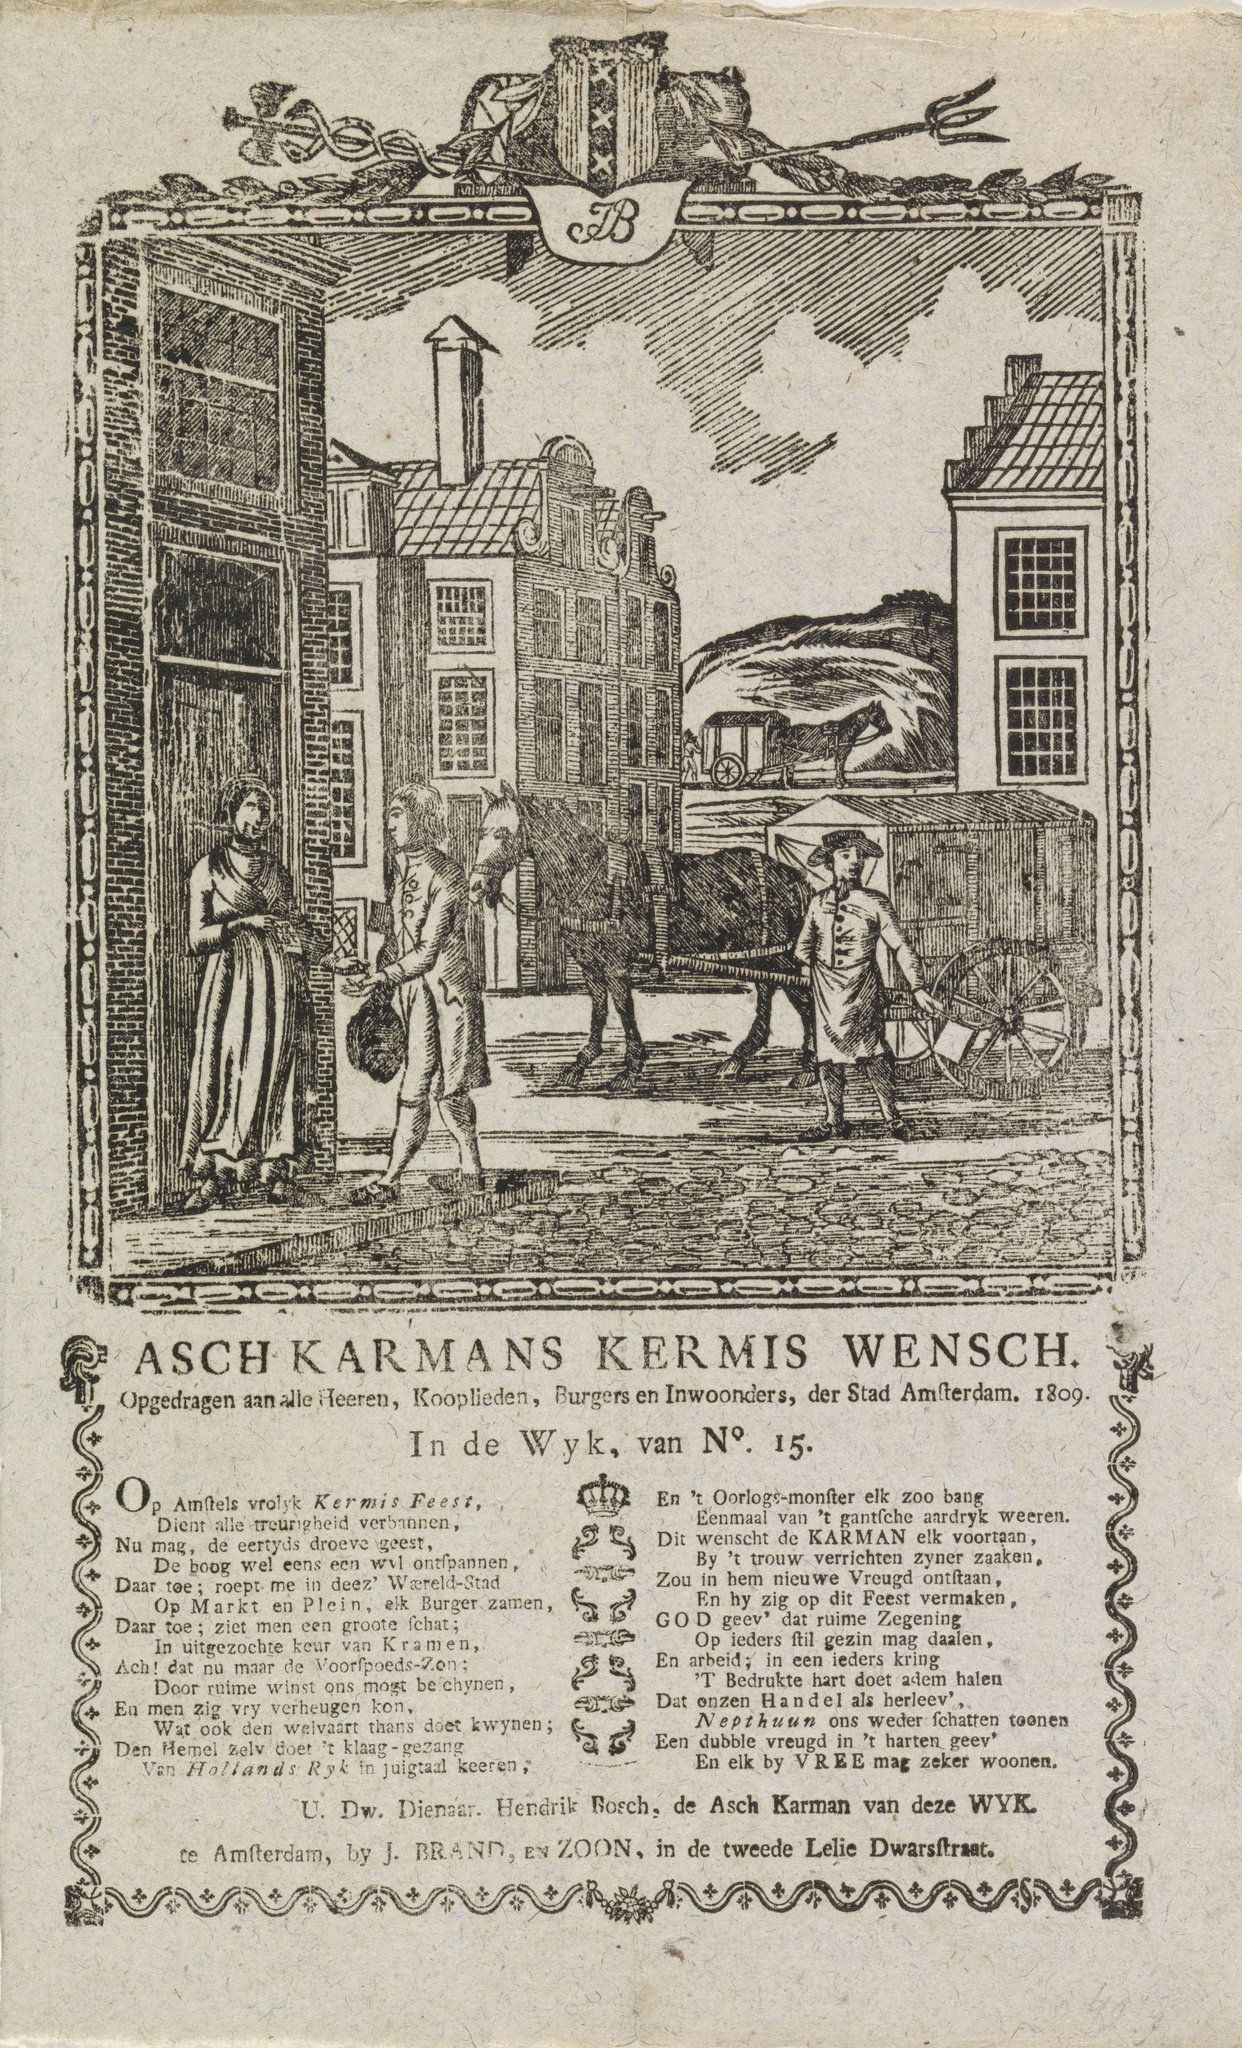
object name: fair print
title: Kermisprent van de Amsterdamse karrenman voor het jaar 1809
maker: j. brand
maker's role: print maker, printer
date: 1809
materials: paper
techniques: letterpress printing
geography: amsterdam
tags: garbage collecting lorry, garbage truck, amsterdam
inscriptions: collector's mark: Lugt 2228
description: Kermisprent voor het jaar 1809 van Hendrik Bosch, de karrenman (askarrenman of vuilnisman) in de wijk 15, opgedragen aan de burgers van Amsterdam. Karrenman met ratelaar en paard met askar in een straat. Bovenaan het wapen van Amsterdam en het monogram JB. Op het blad onder de voorstelling een vers in twee kolommen.